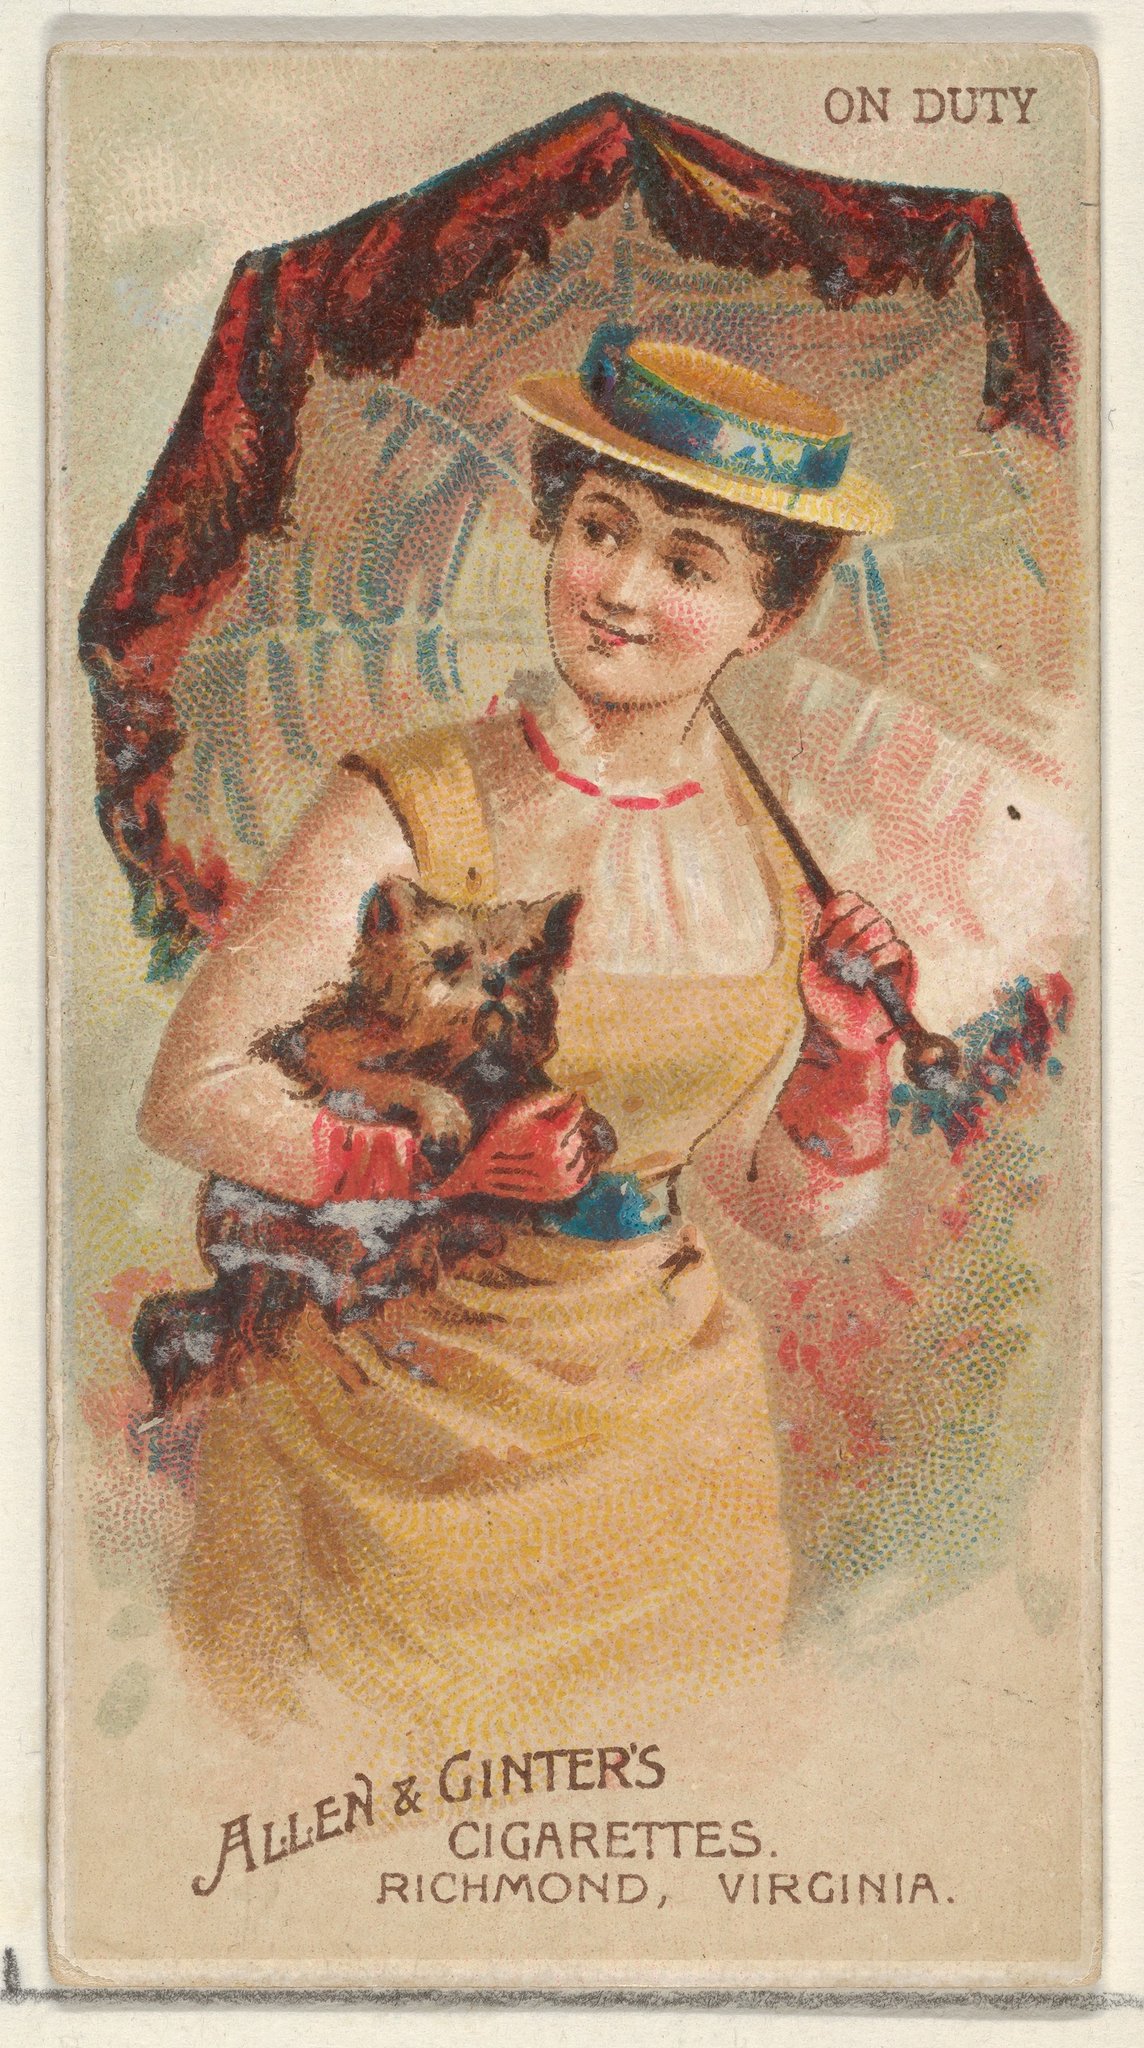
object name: print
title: On Duty, from the Parasol Drills series (N18) for Allen & Ginter Cigarettes Brands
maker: allen & ginter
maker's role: publisher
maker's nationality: american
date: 1888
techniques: color lithograph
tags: women